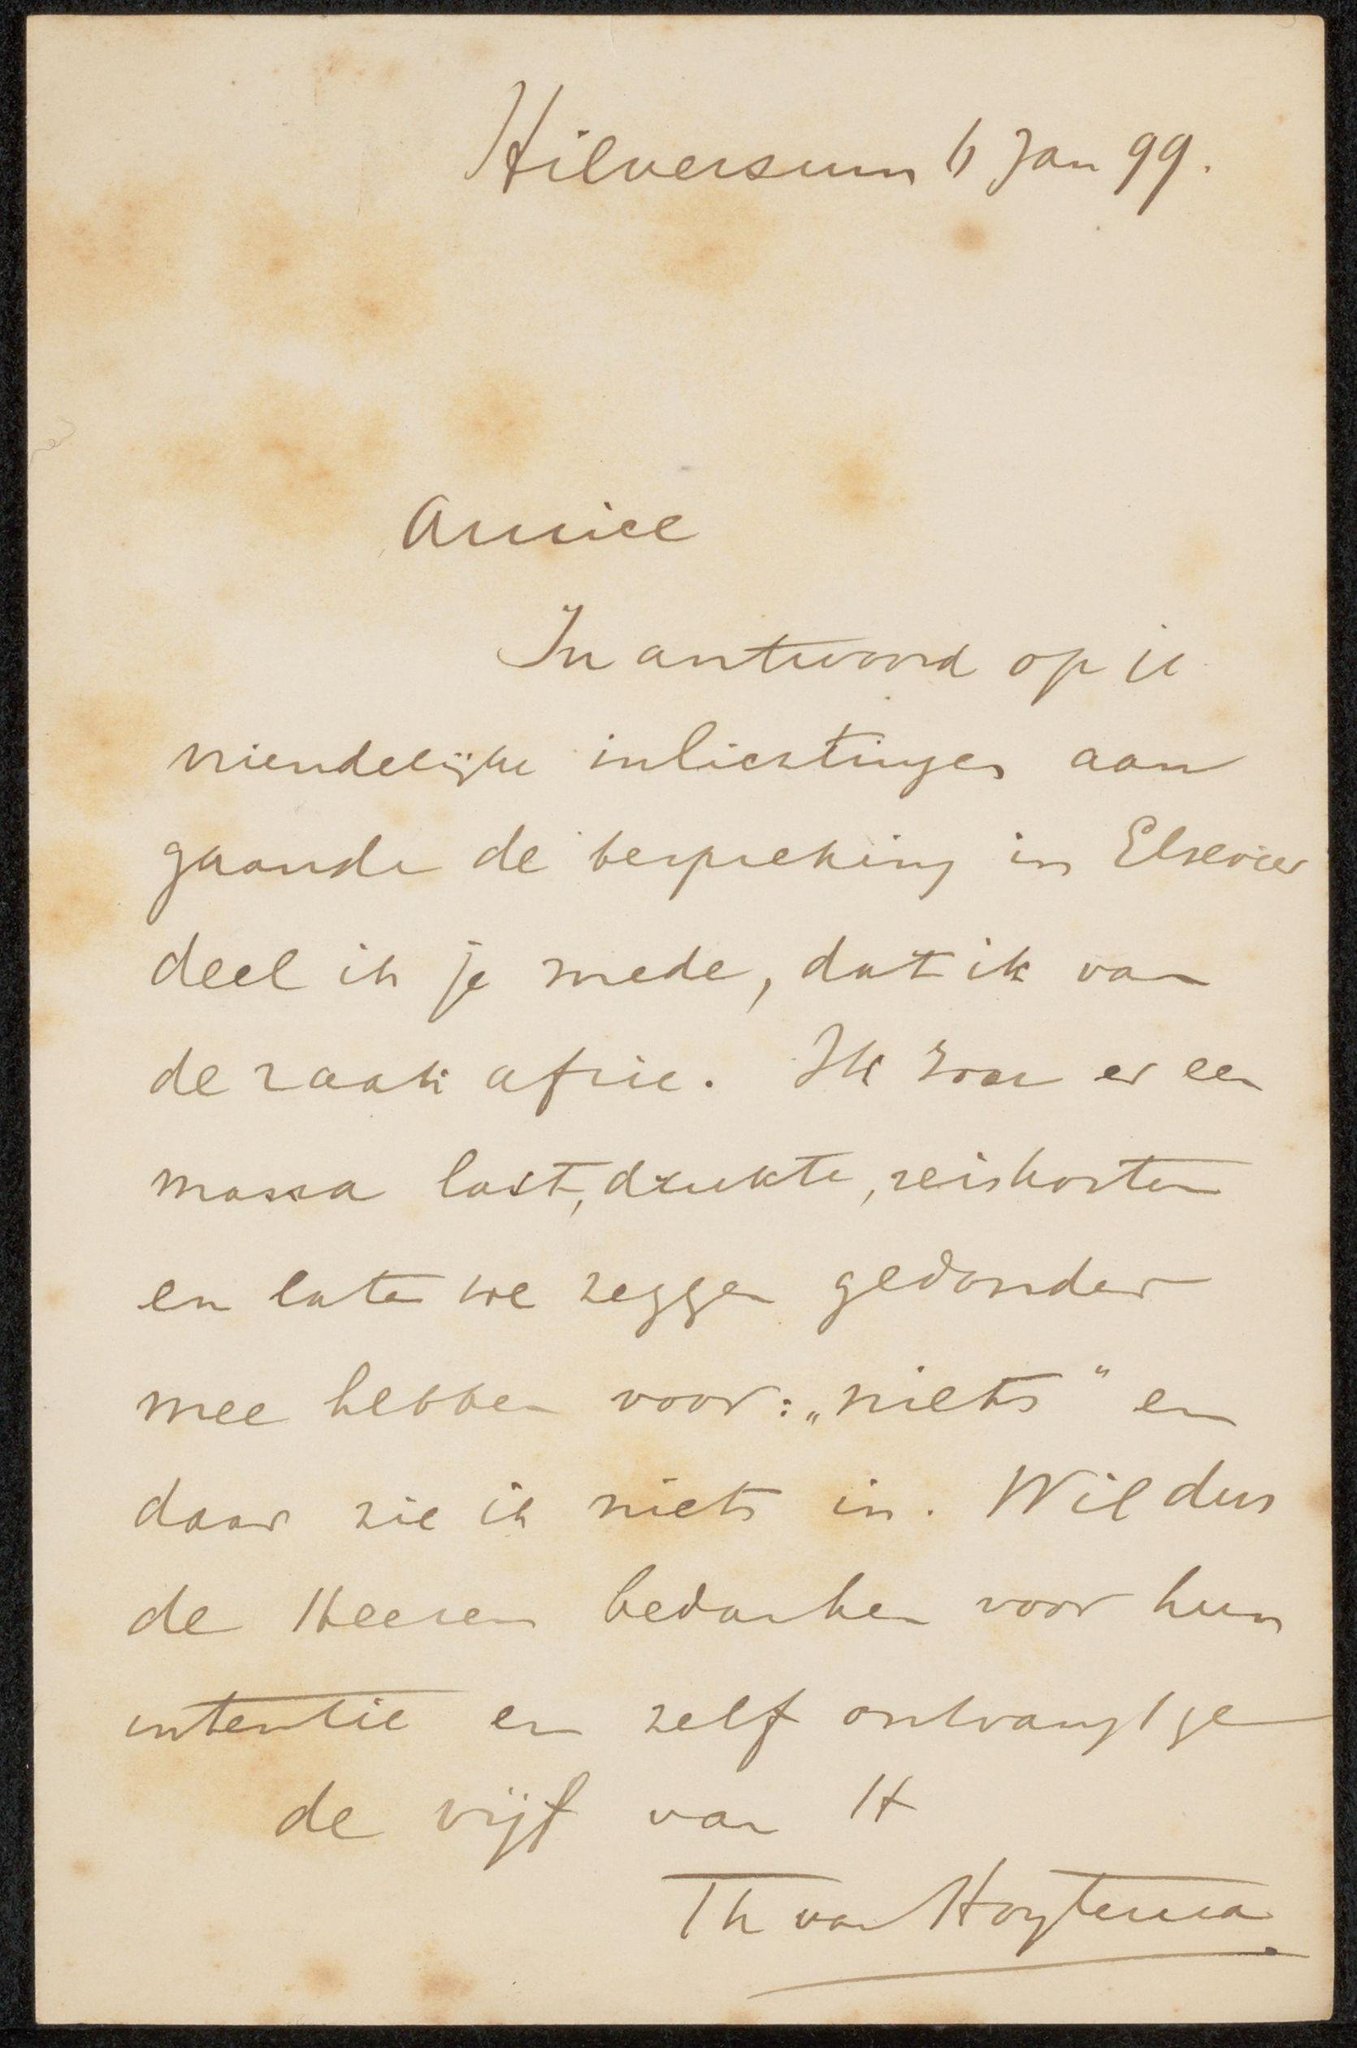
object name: letter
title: Brief aan Philip Zilcken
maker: theo van hoytema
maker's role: draughtsman, painter, print maker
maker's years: 1863-1917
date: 1899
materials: ink, paper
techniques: pen, writing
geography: hilversum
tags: painter, draughtsman, philip zilcken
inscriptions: collector's mark: ‘RPK’